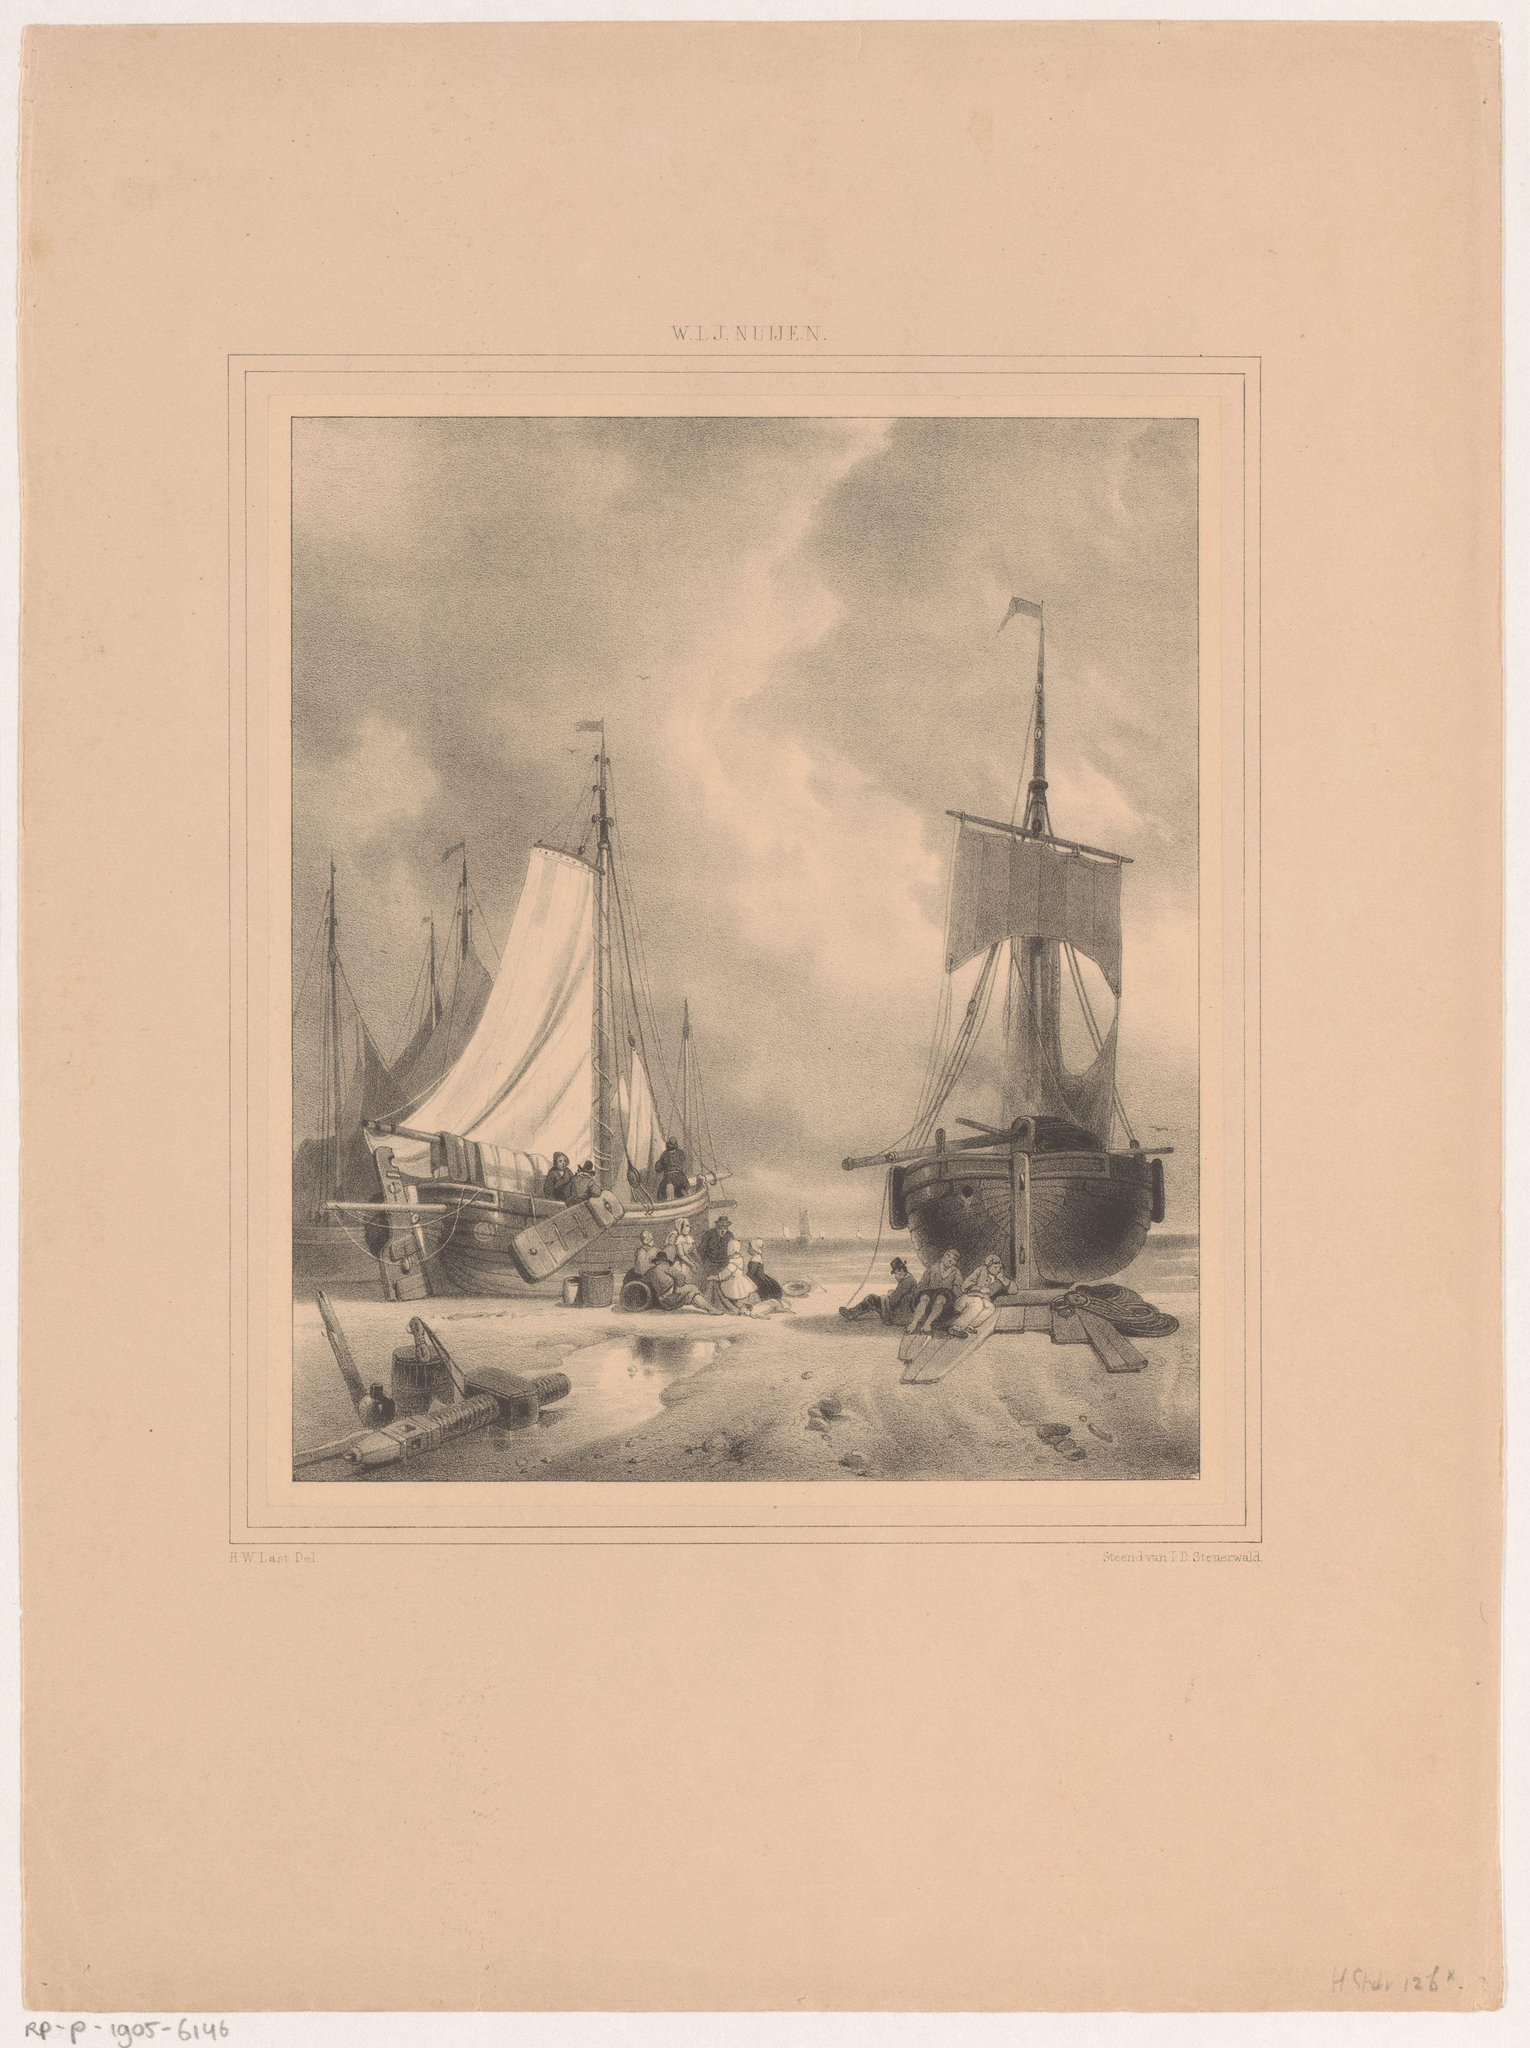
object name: print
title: Platbodems op het strand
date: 1823-1863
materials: paper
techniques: lithograph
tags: sailing-ship, sailing-boat, sea (seascape), ships, boats on land, beached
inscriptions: collector's mark: Lugt 2228